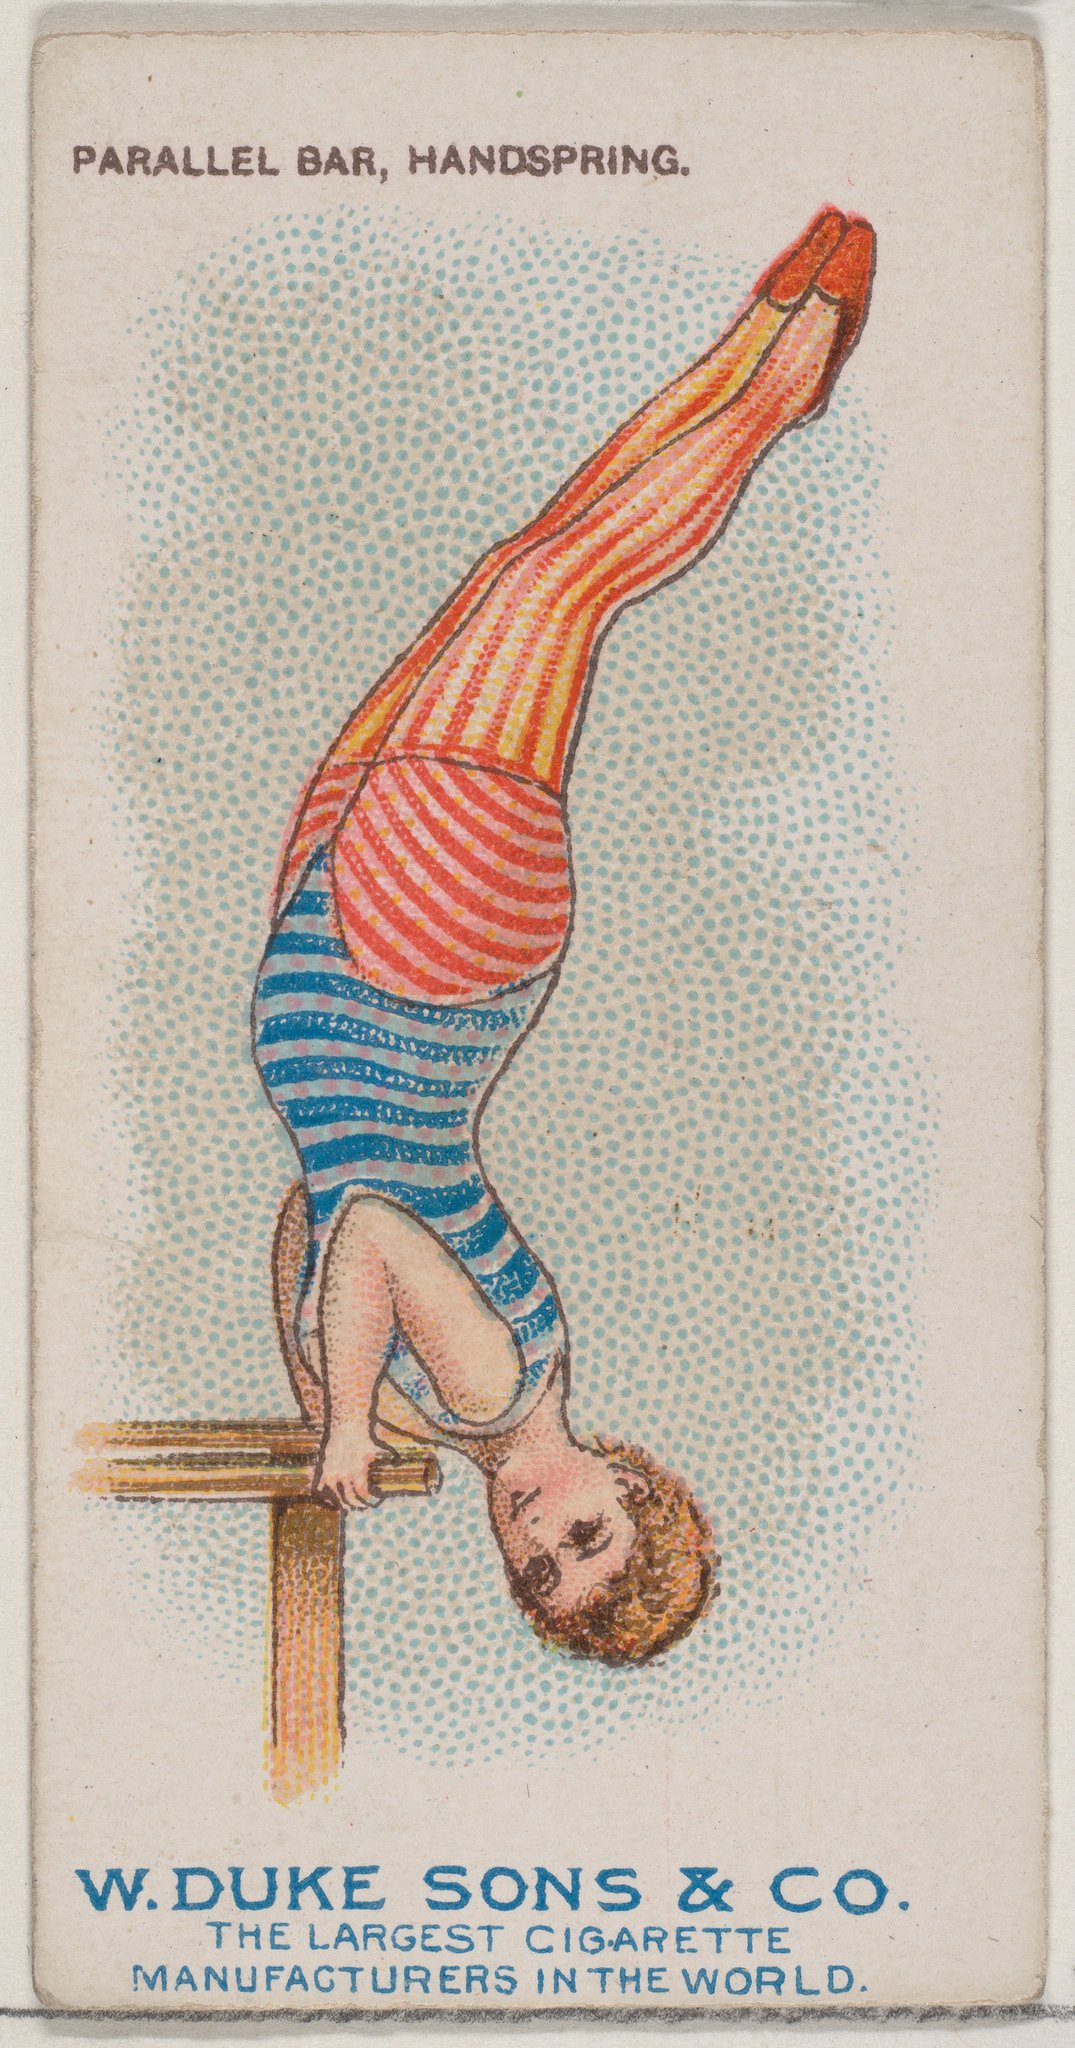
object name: print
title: Parallel Bar, Handspring, from the Gymnastic Exercises series (N77) for Duke brand cigarettes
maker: w. duke, sons & co.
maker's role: publisher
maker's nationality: american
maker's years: 1870-1920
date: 1887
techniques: color lithograph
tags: women,sports,athletes